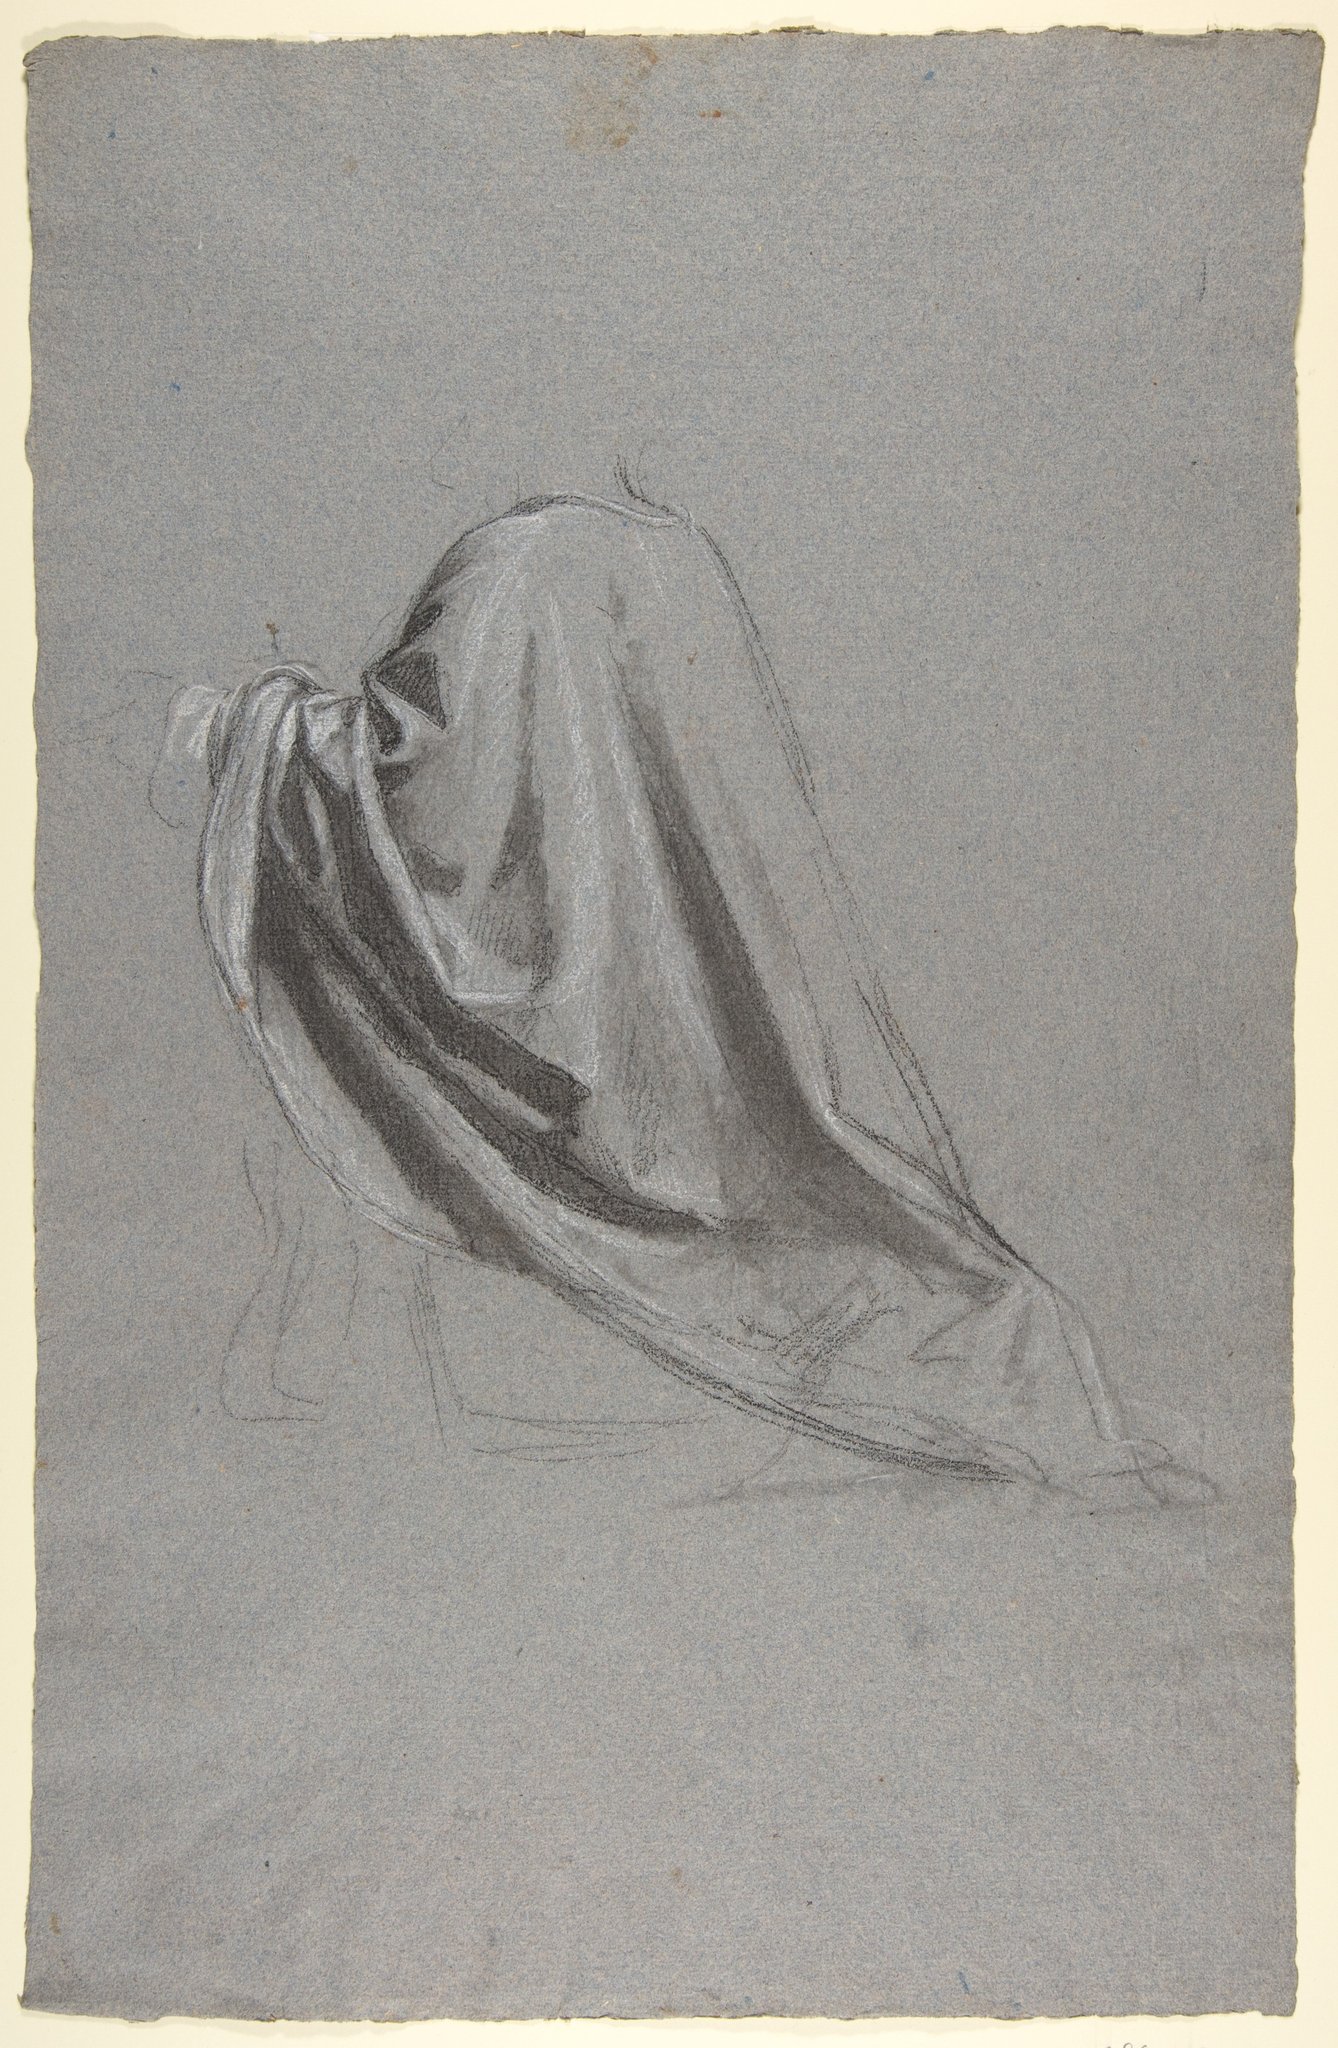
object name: drawing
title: Drapery Study for a Bishop (lower register; study for wall paintings in the Chapel of Saint Remi, Sainte-Clotilde, Paris, 1858)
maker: isidore pils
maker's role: artist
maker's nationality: french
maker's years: 1813-1875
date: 1801-1900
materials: chalk, paper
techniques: heightening, stumping